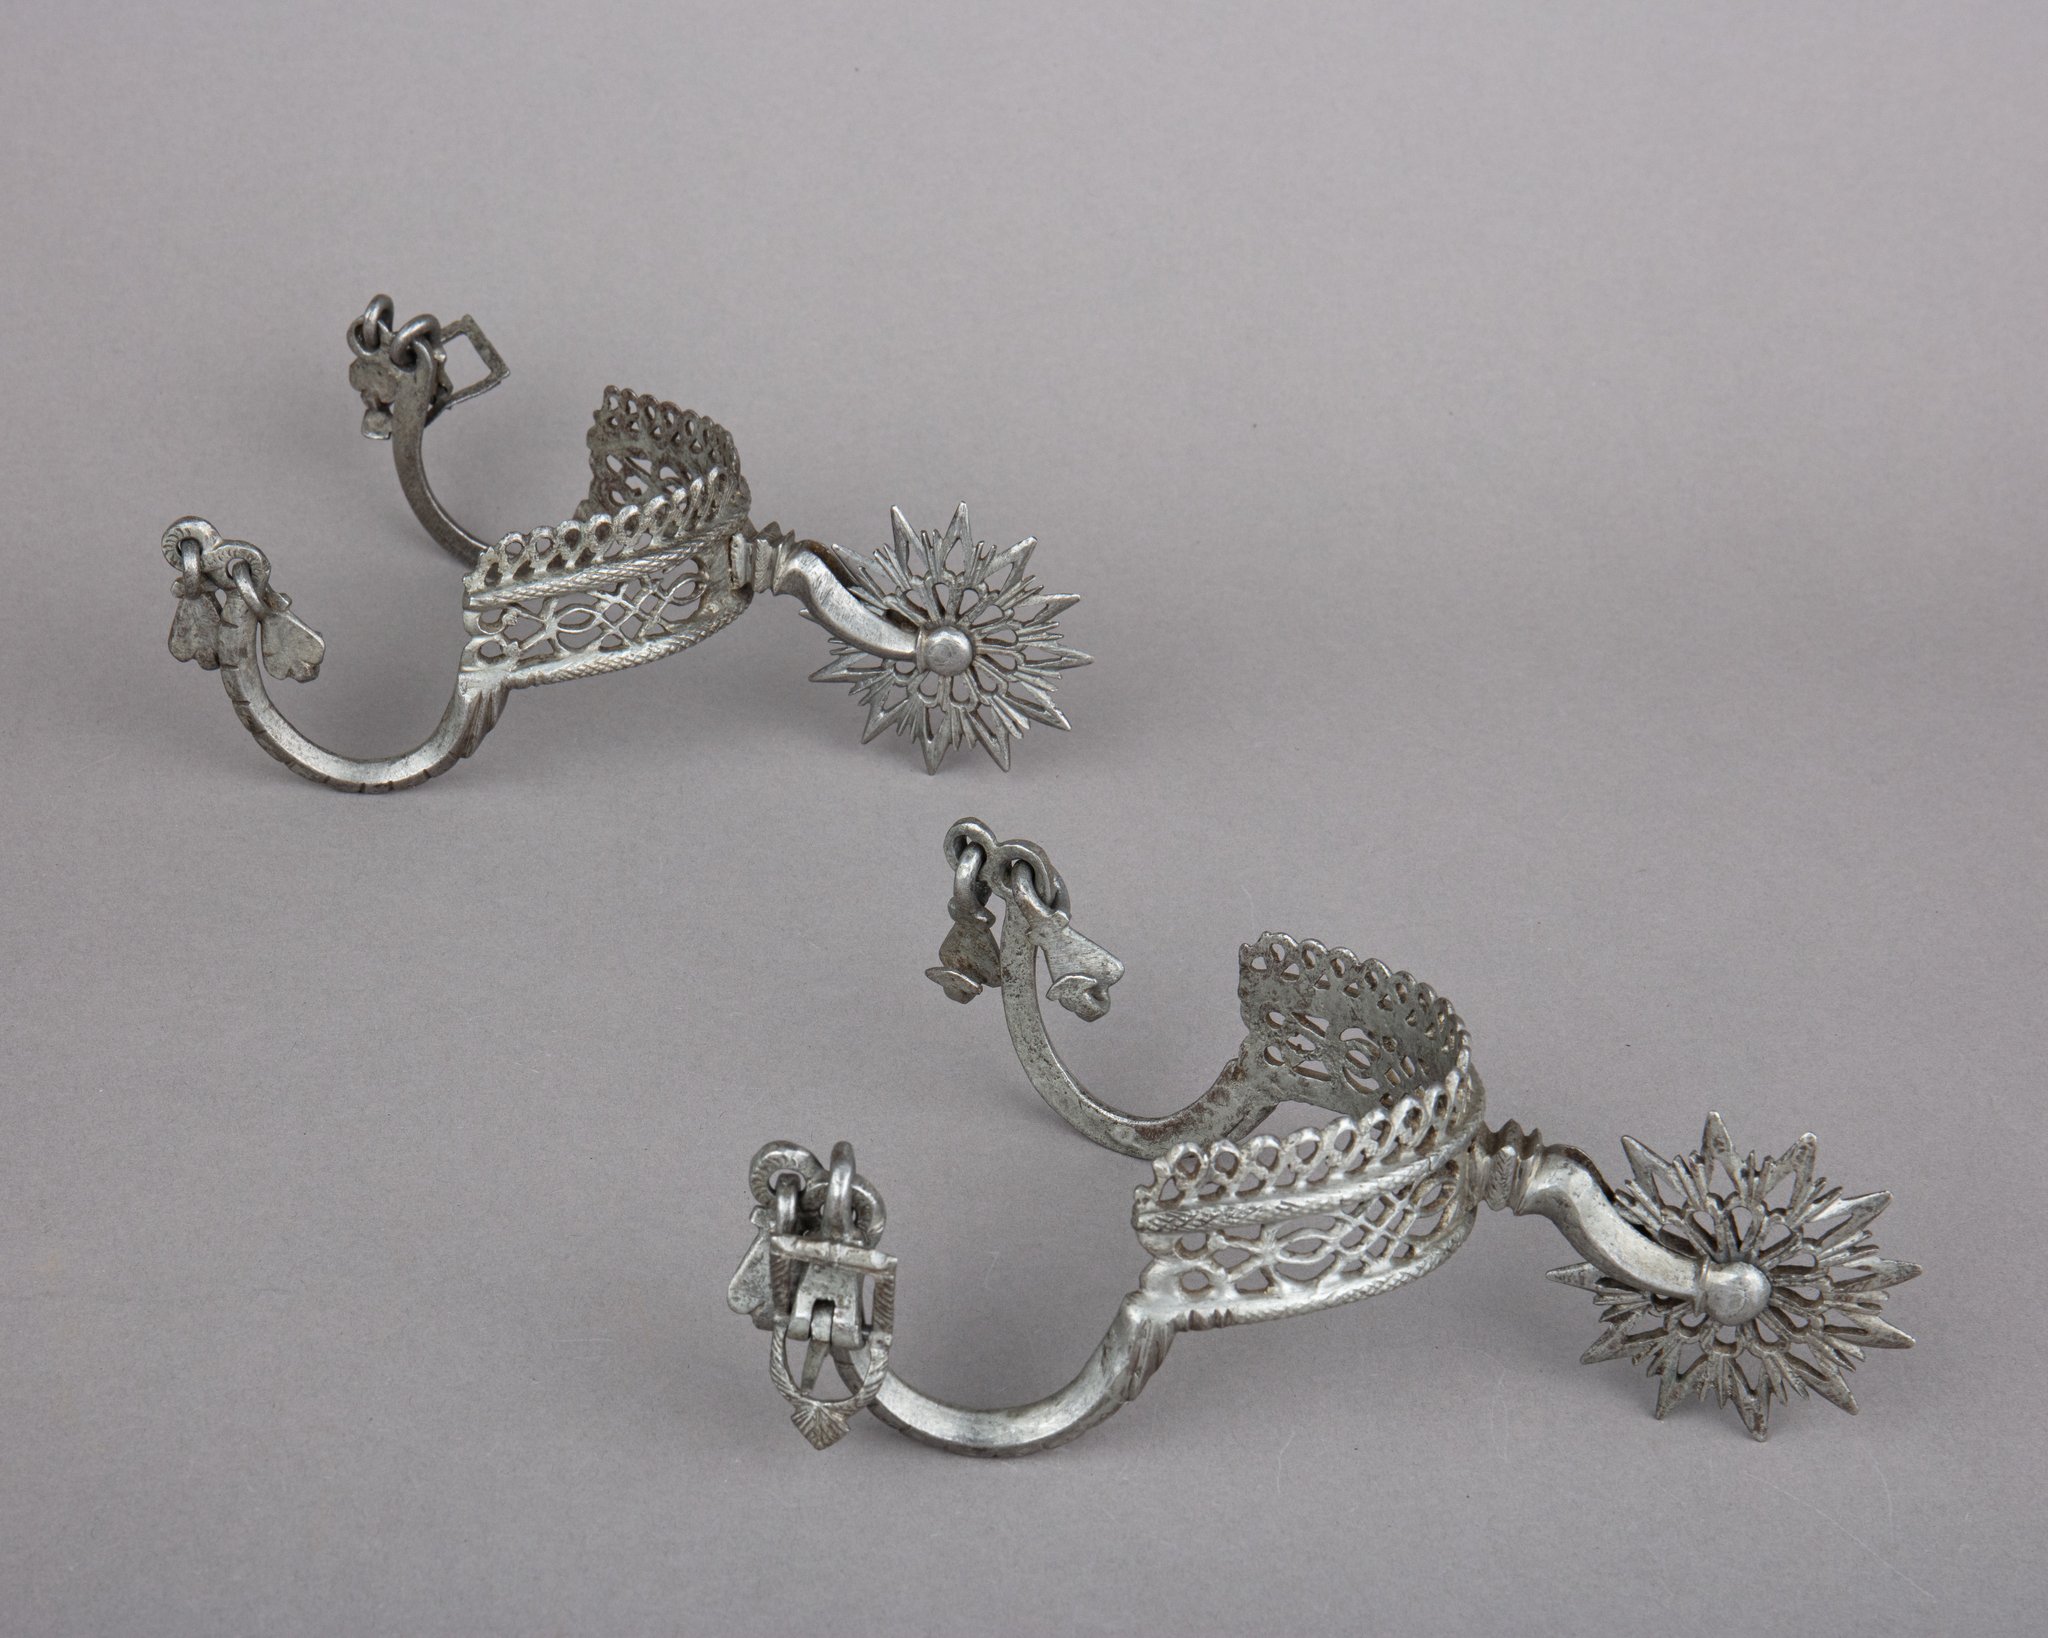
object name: spur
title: Pair of Rowel Spurs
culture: german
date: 1600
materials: metal alloy, tin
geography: germany